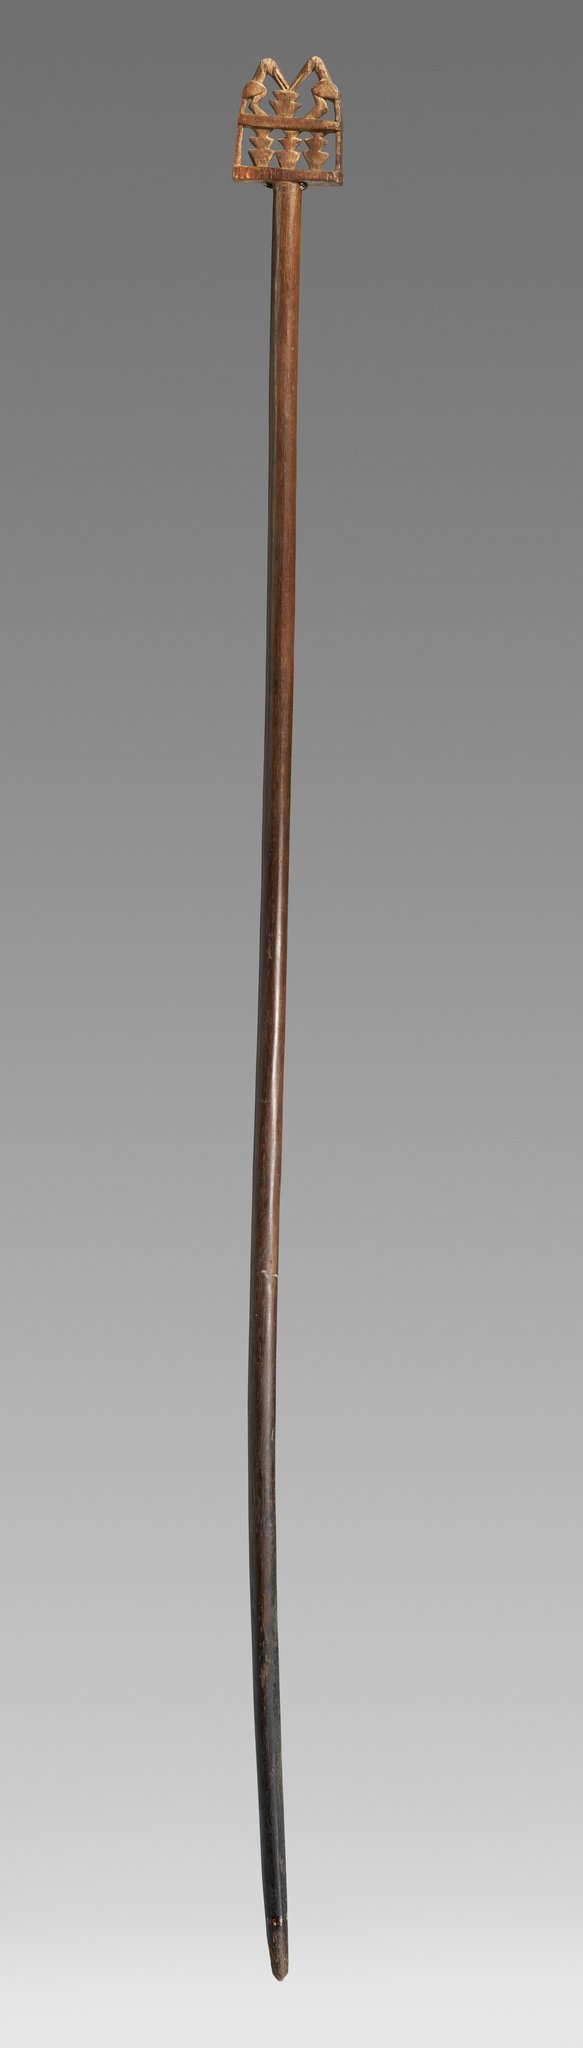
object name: tomb staff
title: Funerary staff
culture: inca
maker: inca artist(s)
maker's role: artist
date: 1400-1535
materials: paint, wood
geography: peru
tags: birds